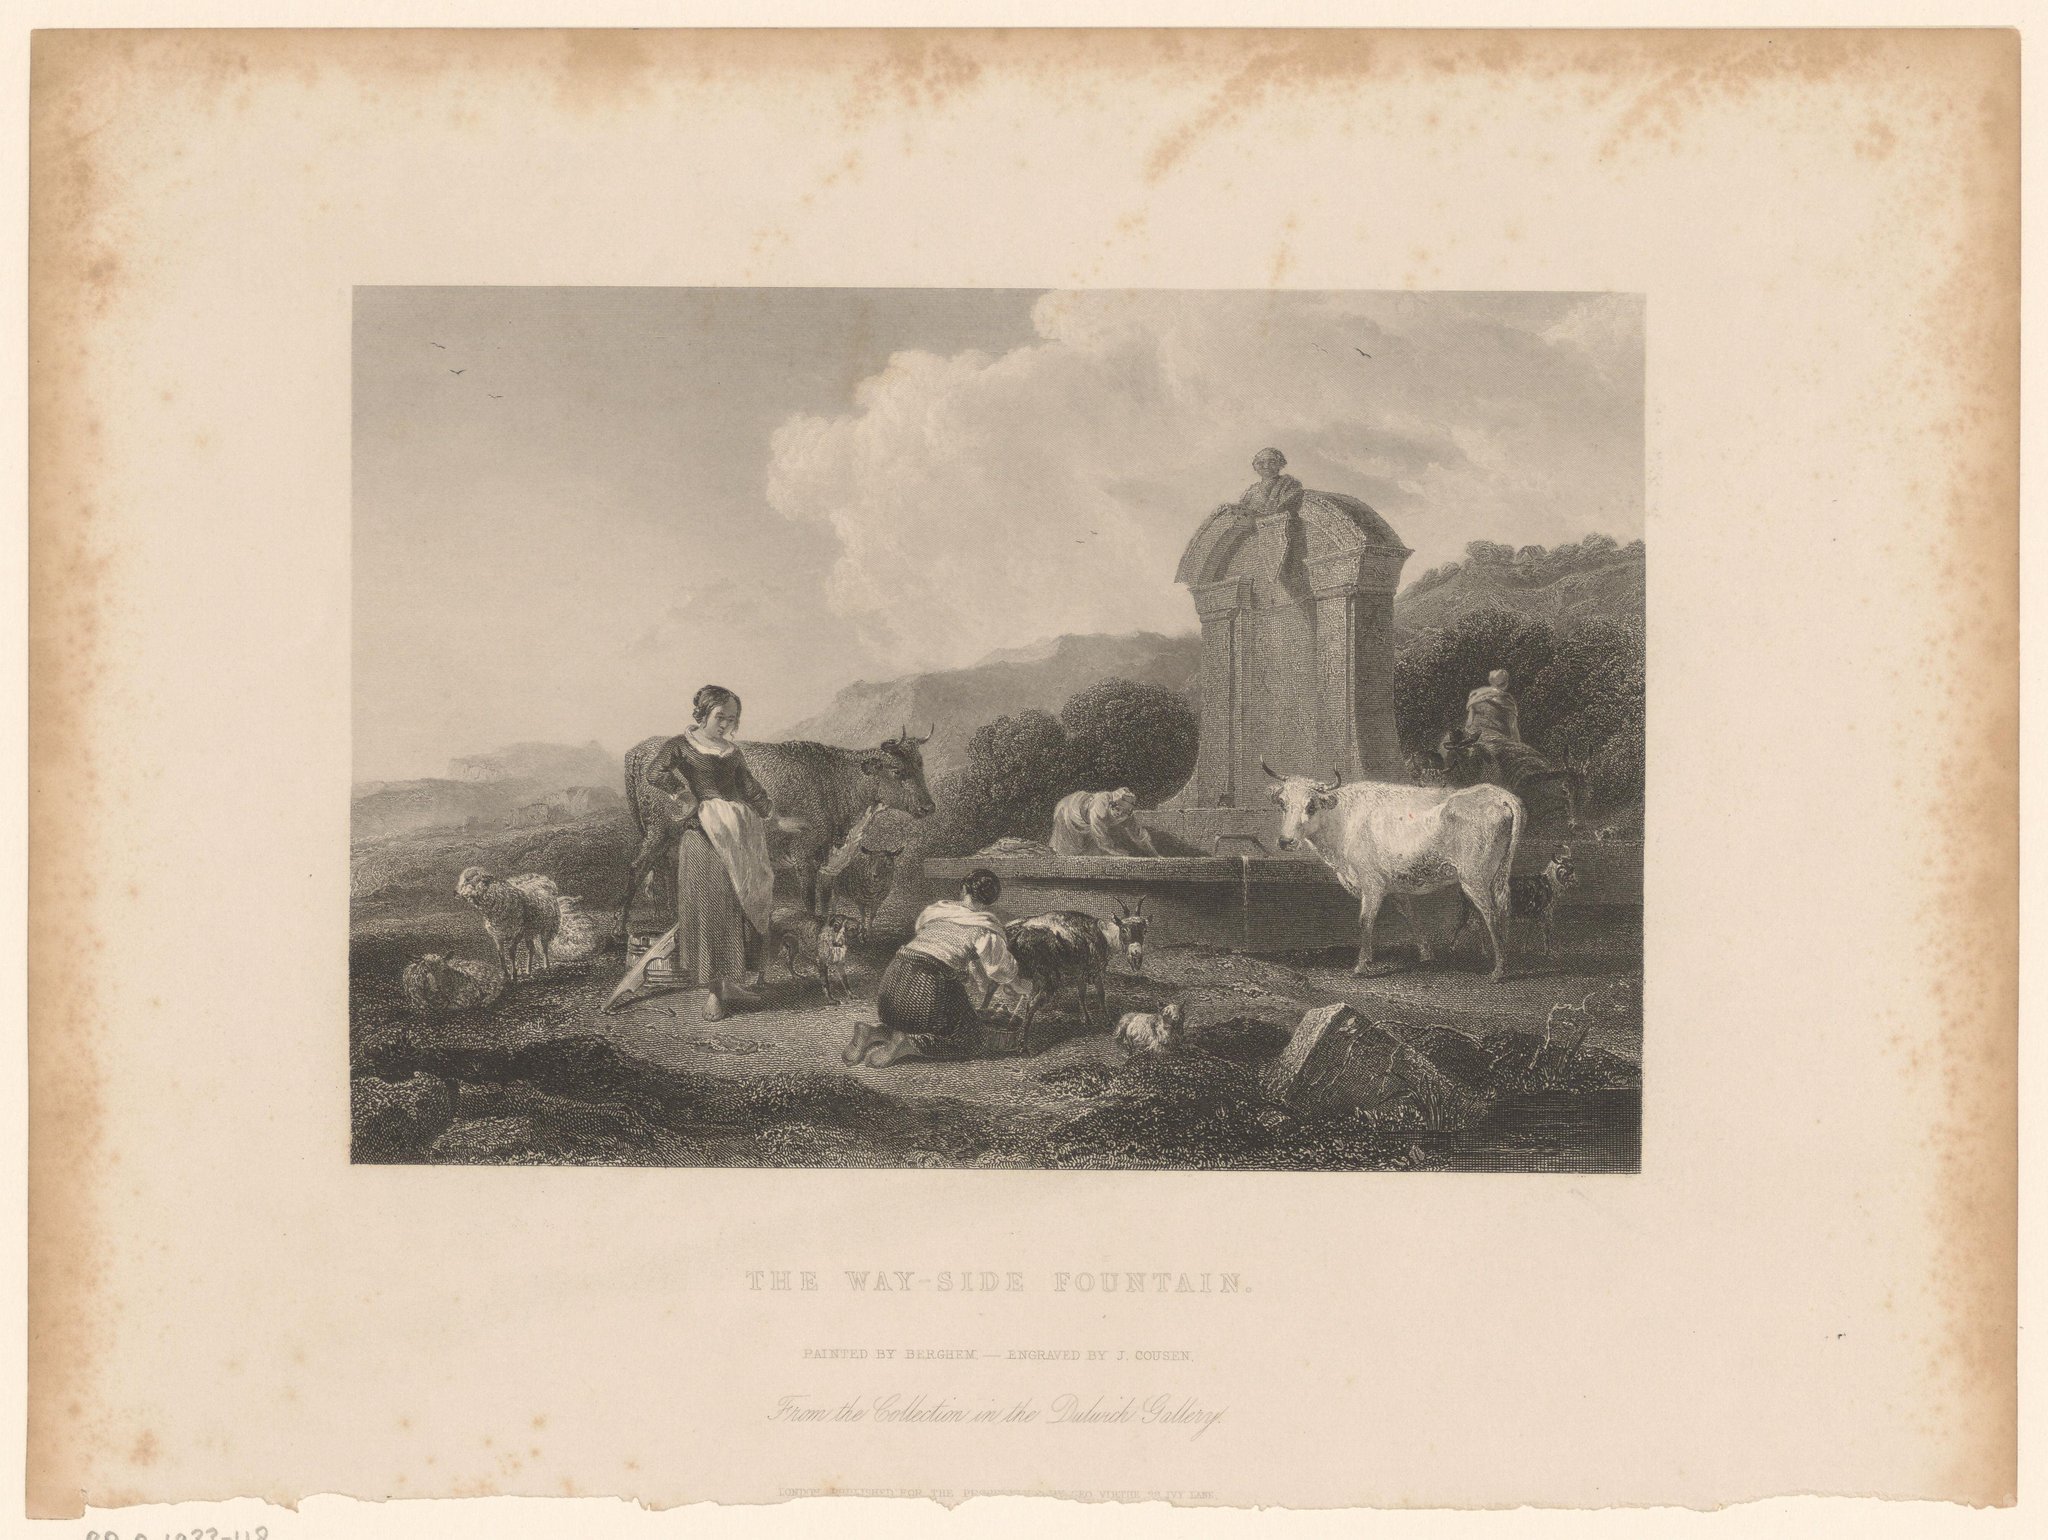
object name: print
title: Landschap met drie herderinnen met koeien en schapen bij een fontein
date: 1846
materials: paper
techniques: etching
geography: england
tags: cow, herding, herdsman, herdswoman, shepherd, shepherdess, cowherd, etc., sheep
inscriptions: collector's mark: Lugt 2233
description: Prent uit: Hall, Samuel Carter. Gems of European Art: the best pictures of the best schools. Londen: George Virtue, 1846, dl. 1.